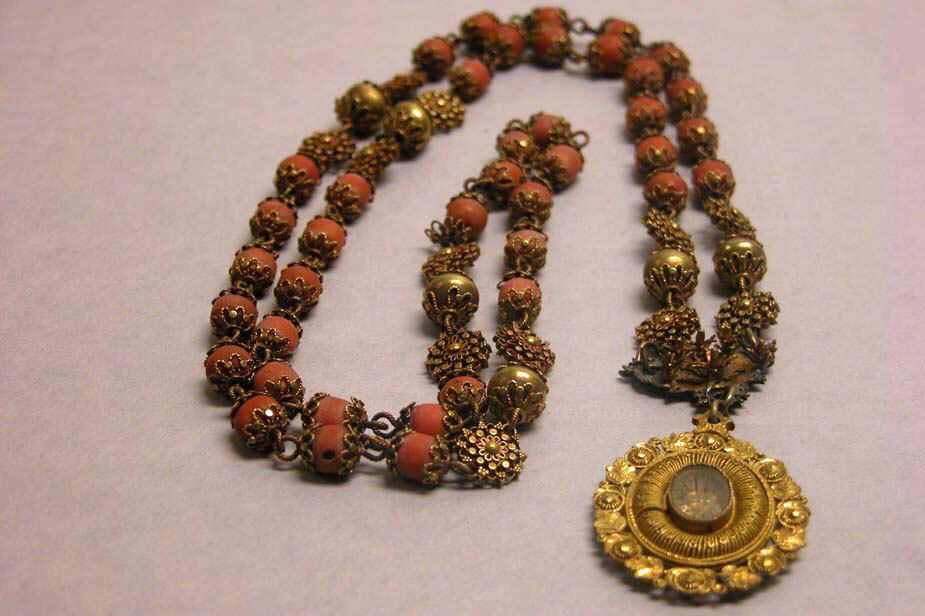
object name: necklace or rosary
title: Necklace or Rosary (?)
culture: filipino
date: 1601-1900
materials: coral, gold